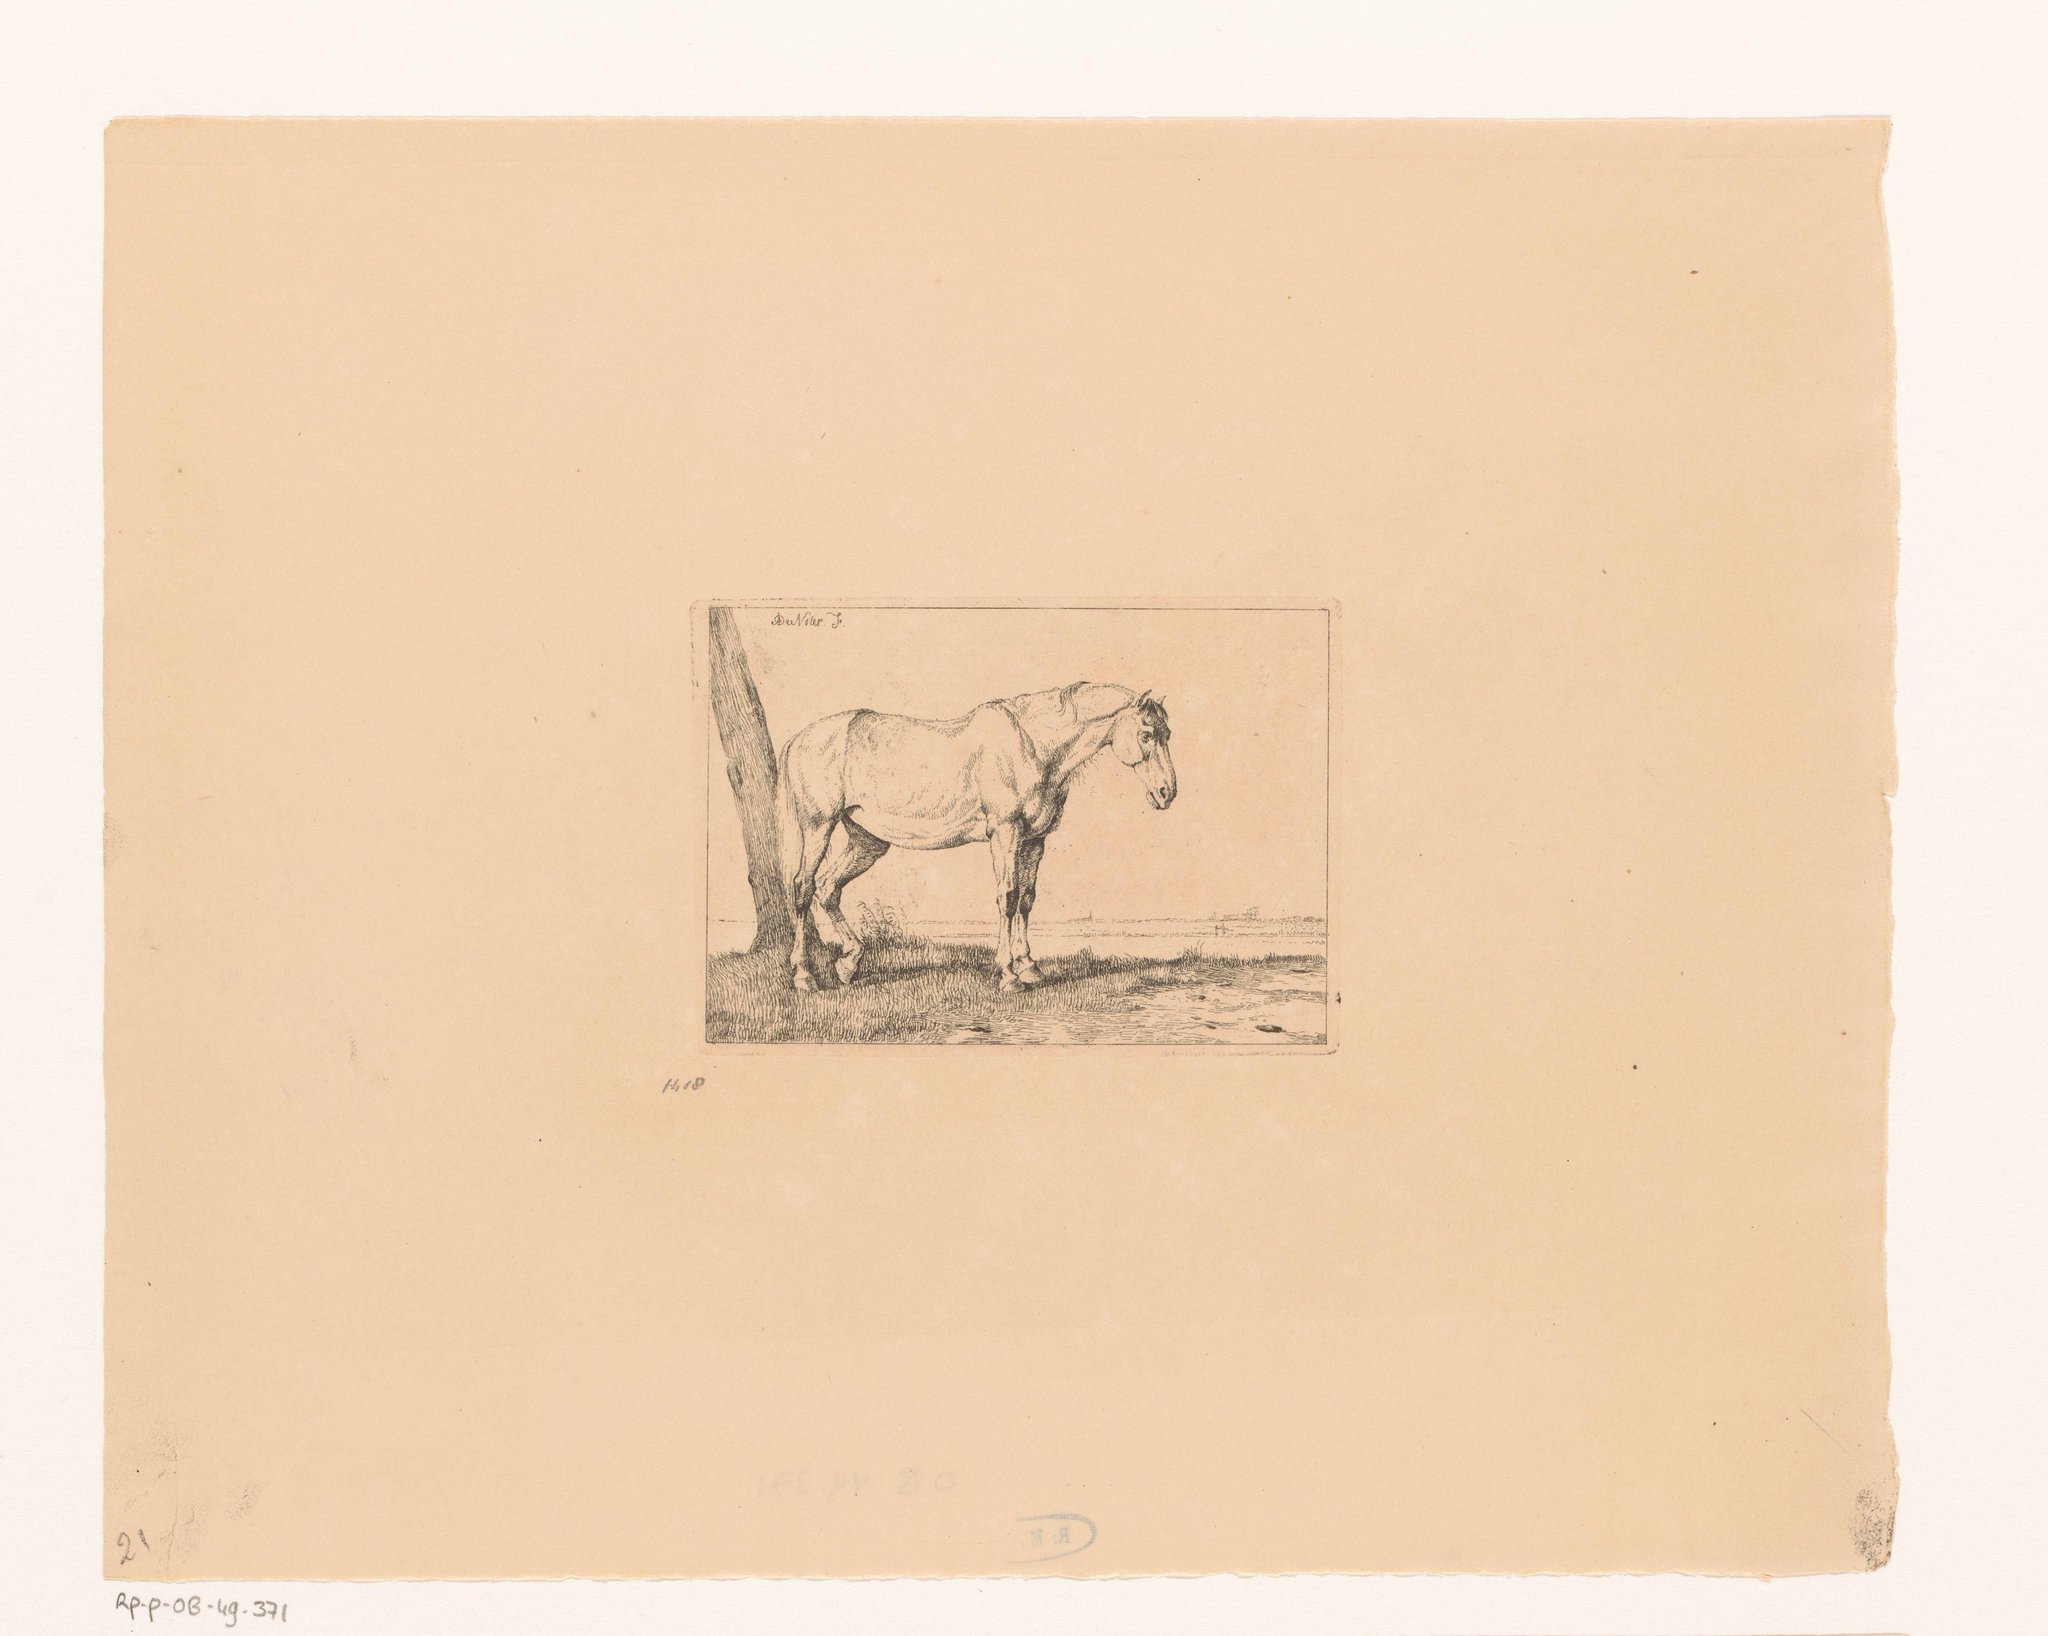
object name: print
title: Paard bij een boomstam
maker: auguste herman marie de noter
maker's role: print maker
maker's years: 1806-1838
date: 1816-1837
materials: paper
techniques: etching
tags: landscapes, horse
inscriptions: collector's mark: Lugt 2228